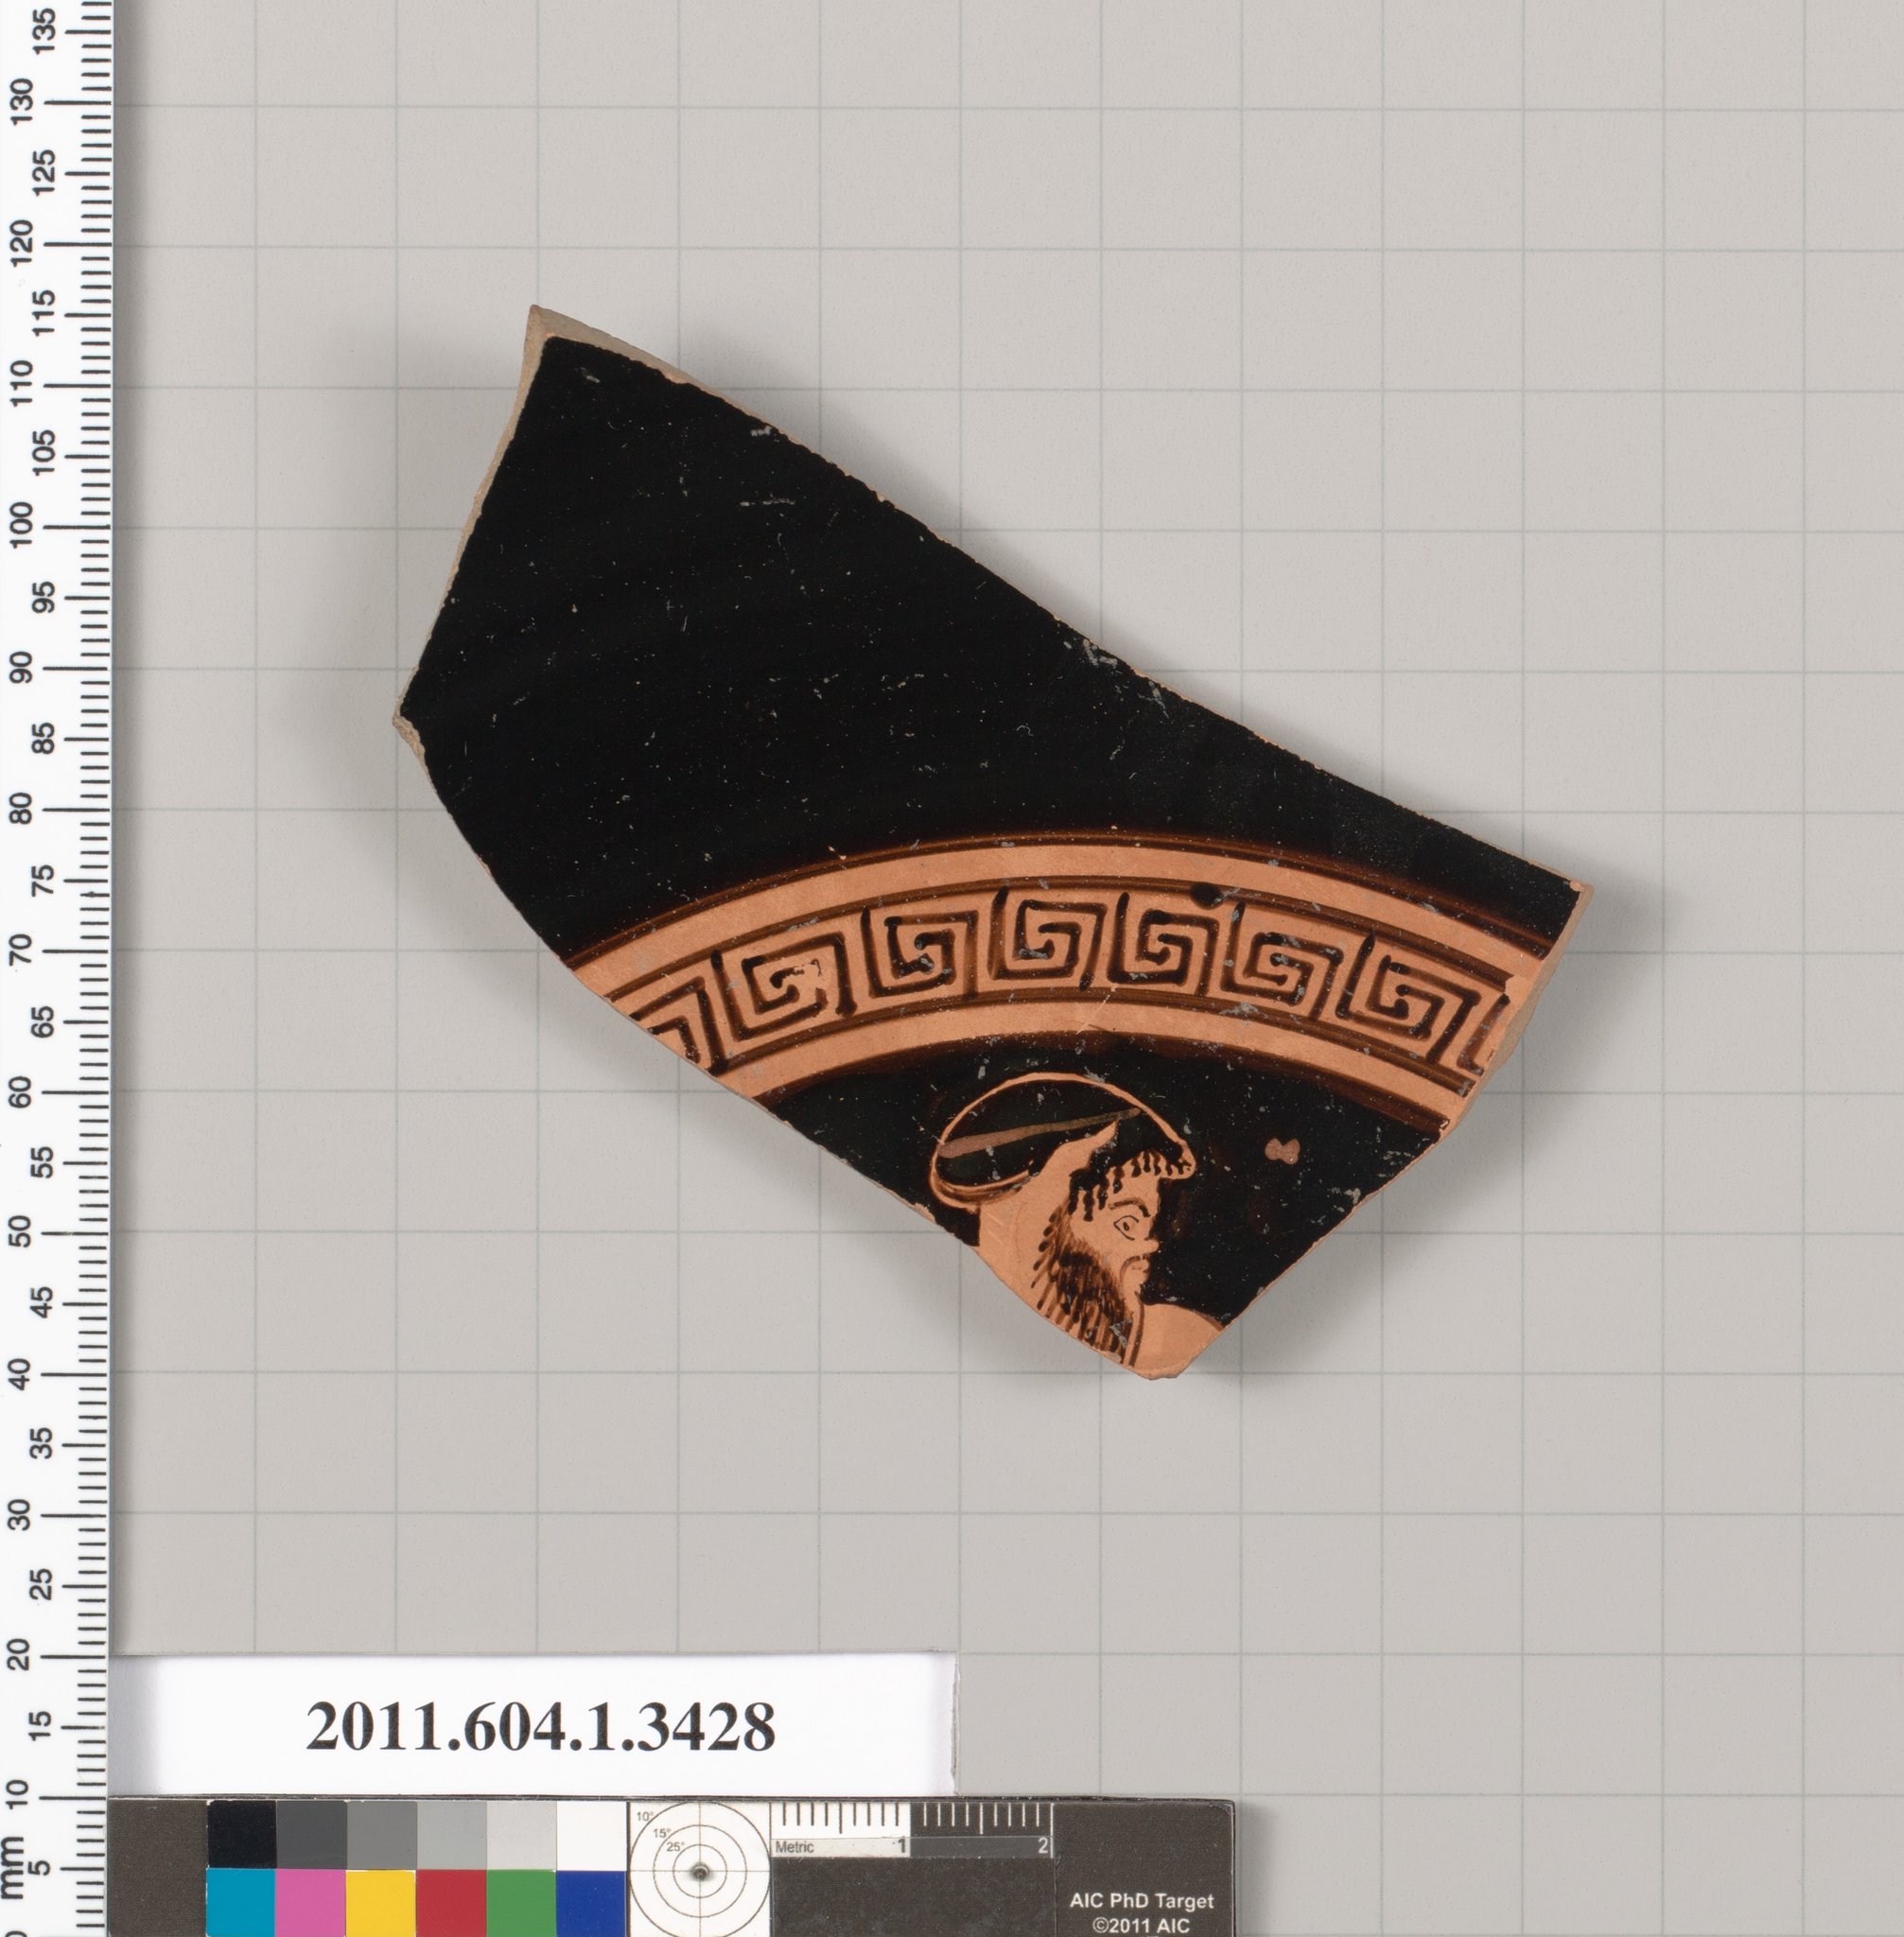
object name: kylix fragment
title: Terracotta fragment of a kylix (drinking cup)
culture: greek, attic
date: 490-480 BCE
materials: terracotta